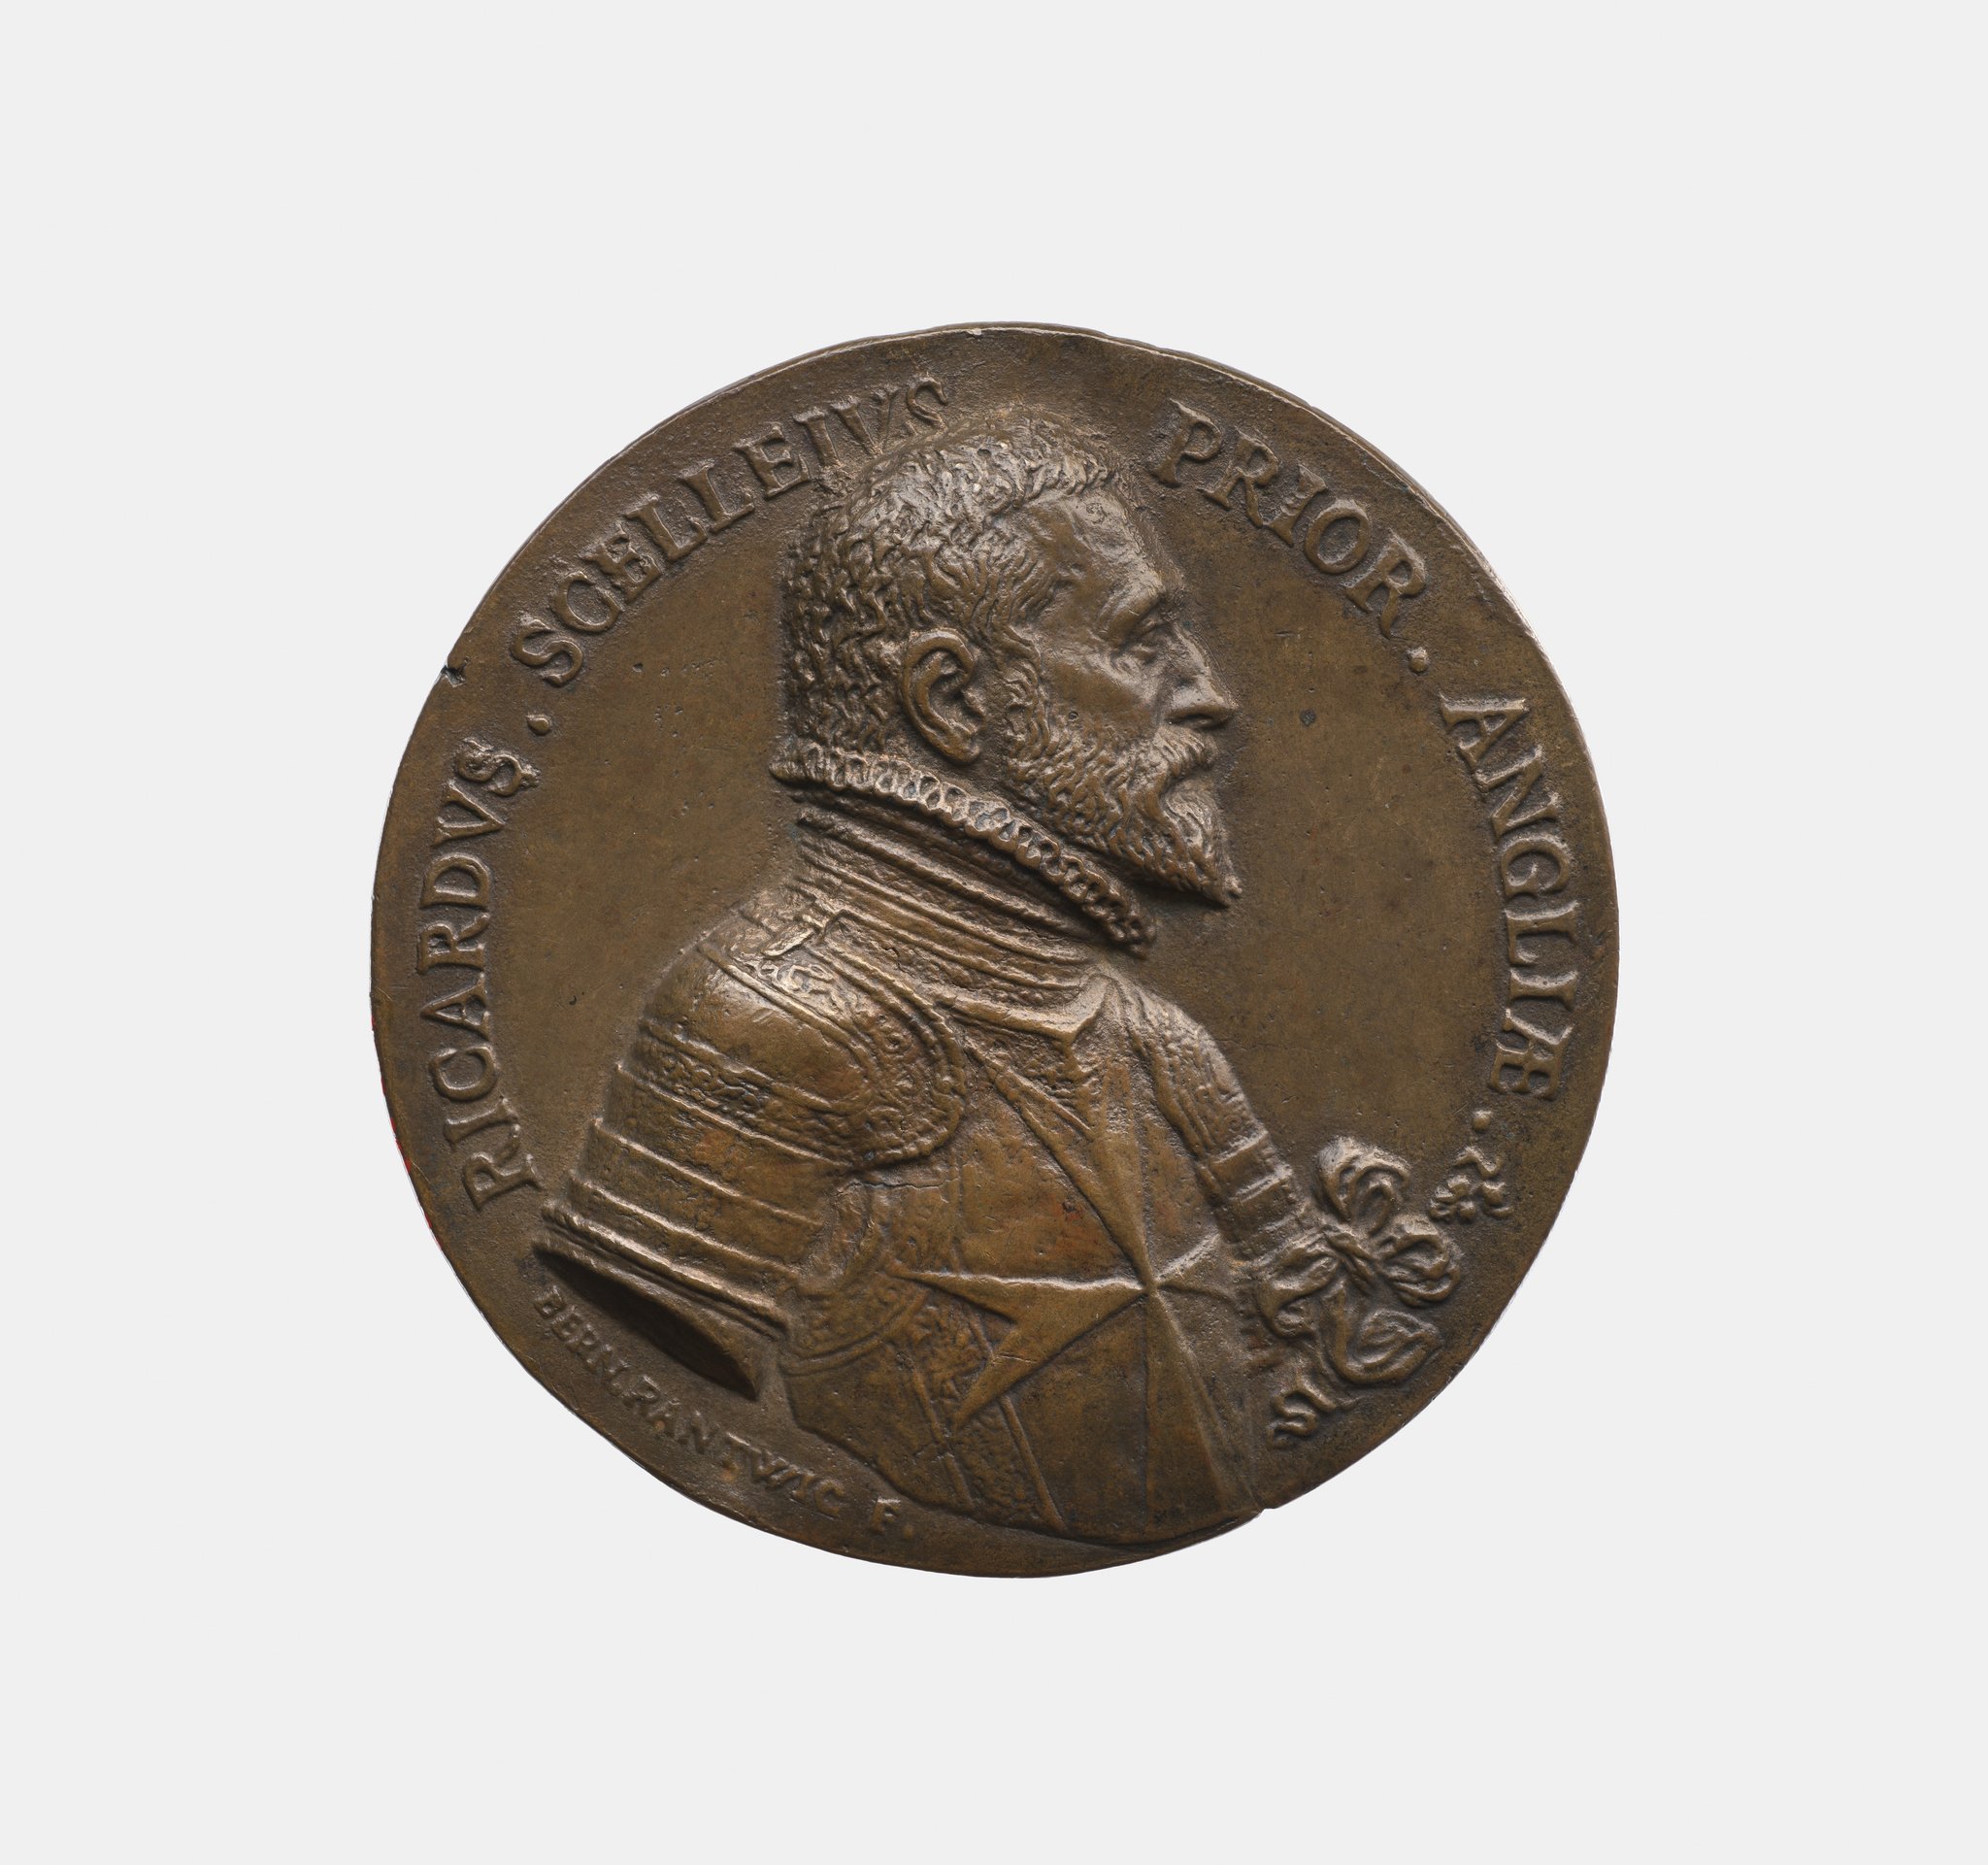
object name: medal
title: Sir Richard Shelley ca. 1513-ca. 1589 Prior of the English Nation of the Knights of Malta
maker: bernard rantwic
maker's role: artist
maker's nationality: german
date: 1500-1599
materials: bronze